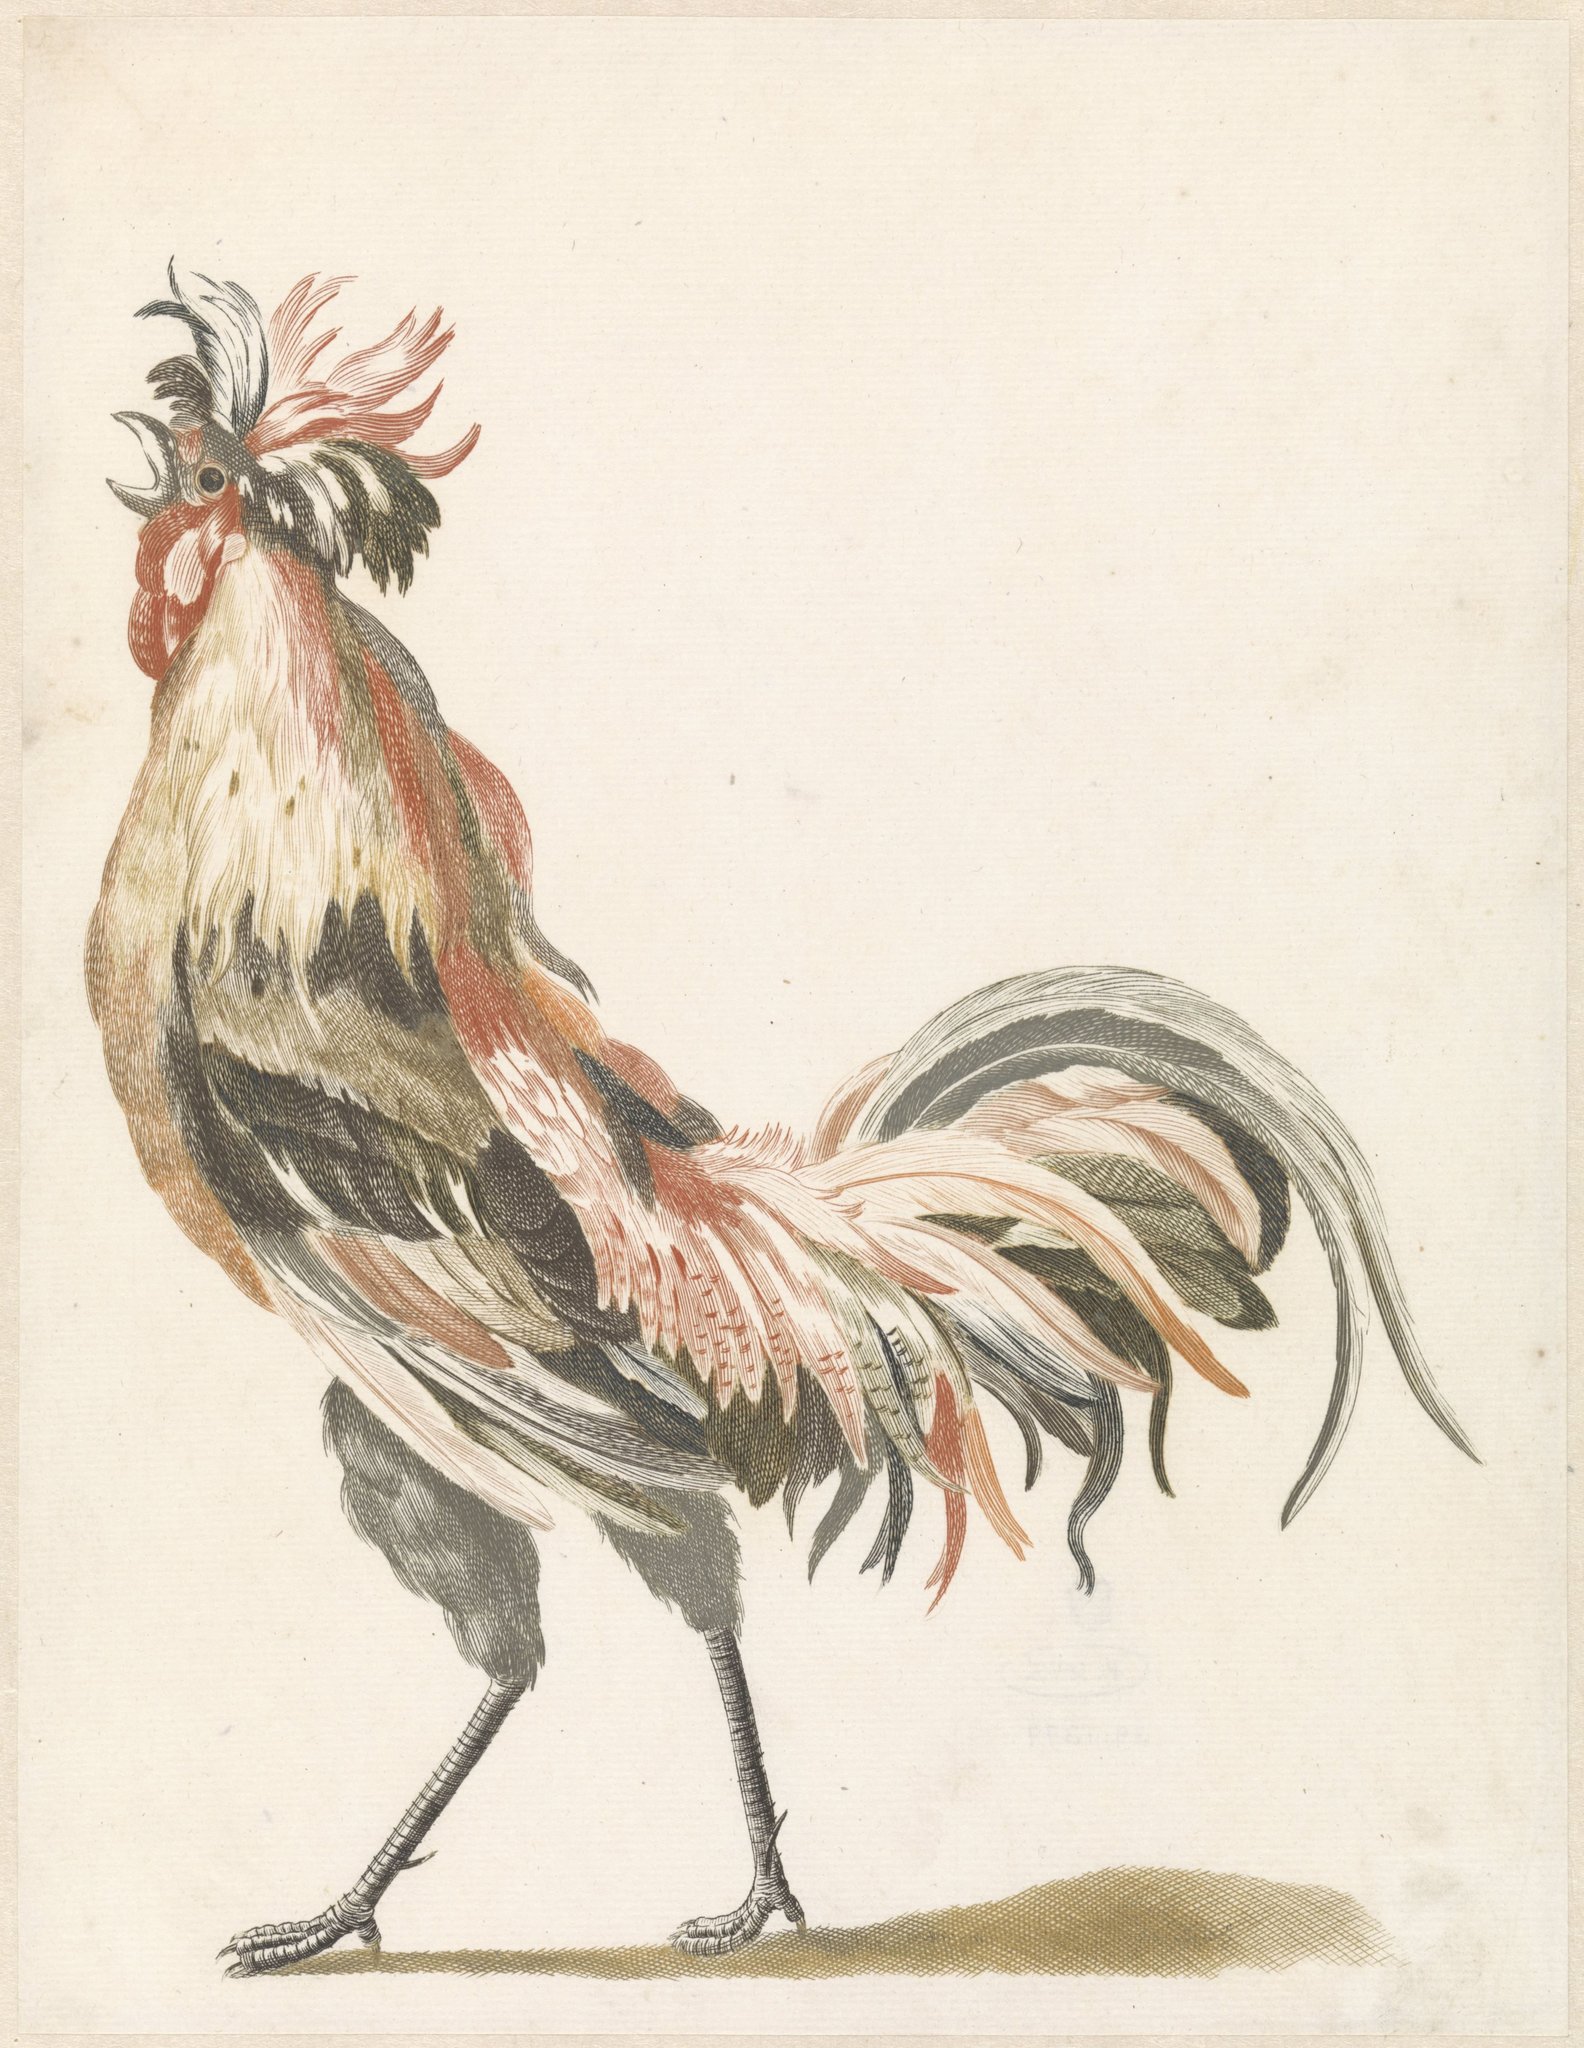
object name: print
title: Kraaiende haan naar links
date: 1688-1698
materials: paper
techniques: printing, engraving, lithography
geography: netherlands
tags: fowl (cock, hen, chicken, etc.)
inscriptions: collector's mark: Lugt 2228, collector's mark: Lugt 2760